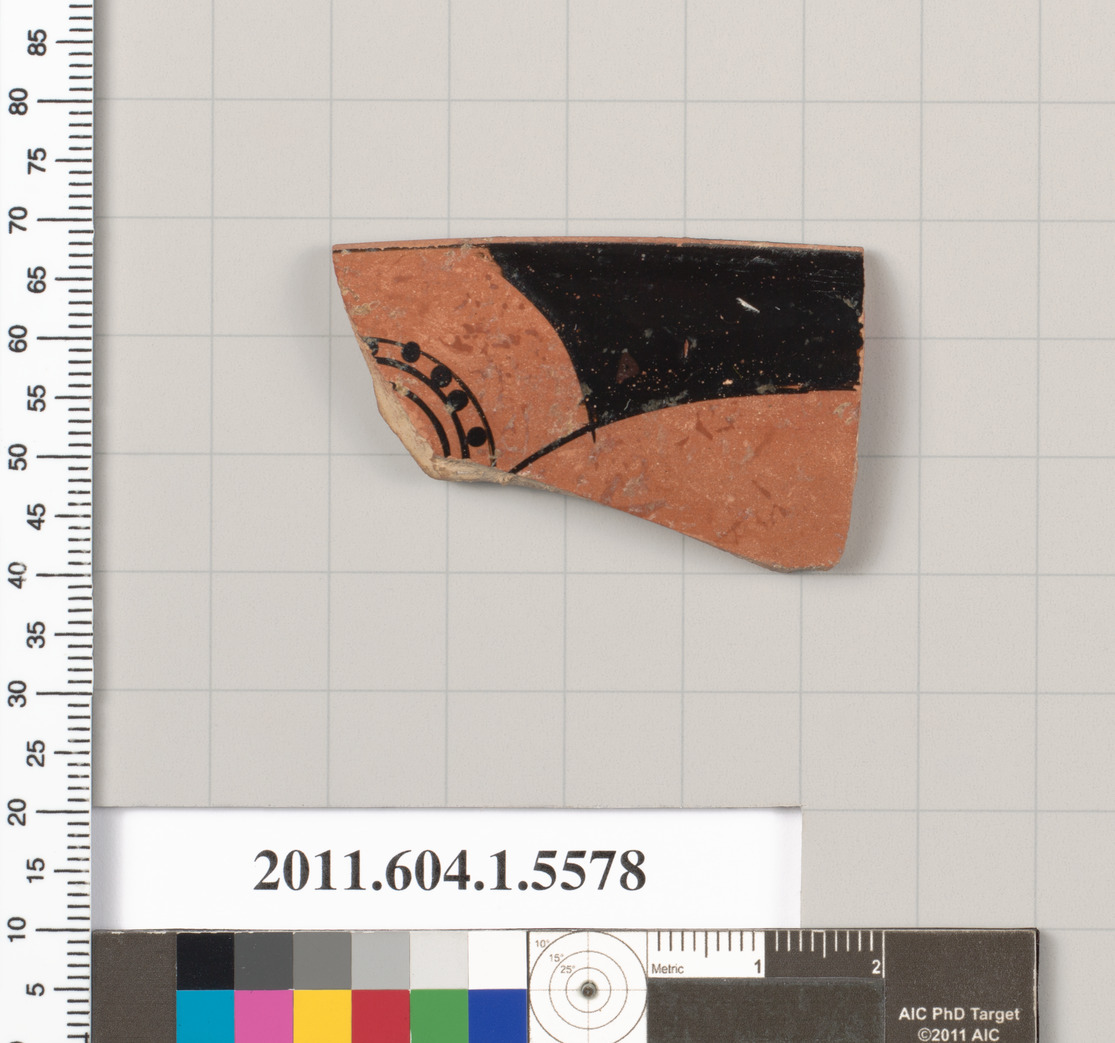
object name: kylix fragment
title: Terracotta rim fragment of a kylix (drinking cup)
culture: greek, attic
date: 520-500 BCE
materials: terracotta